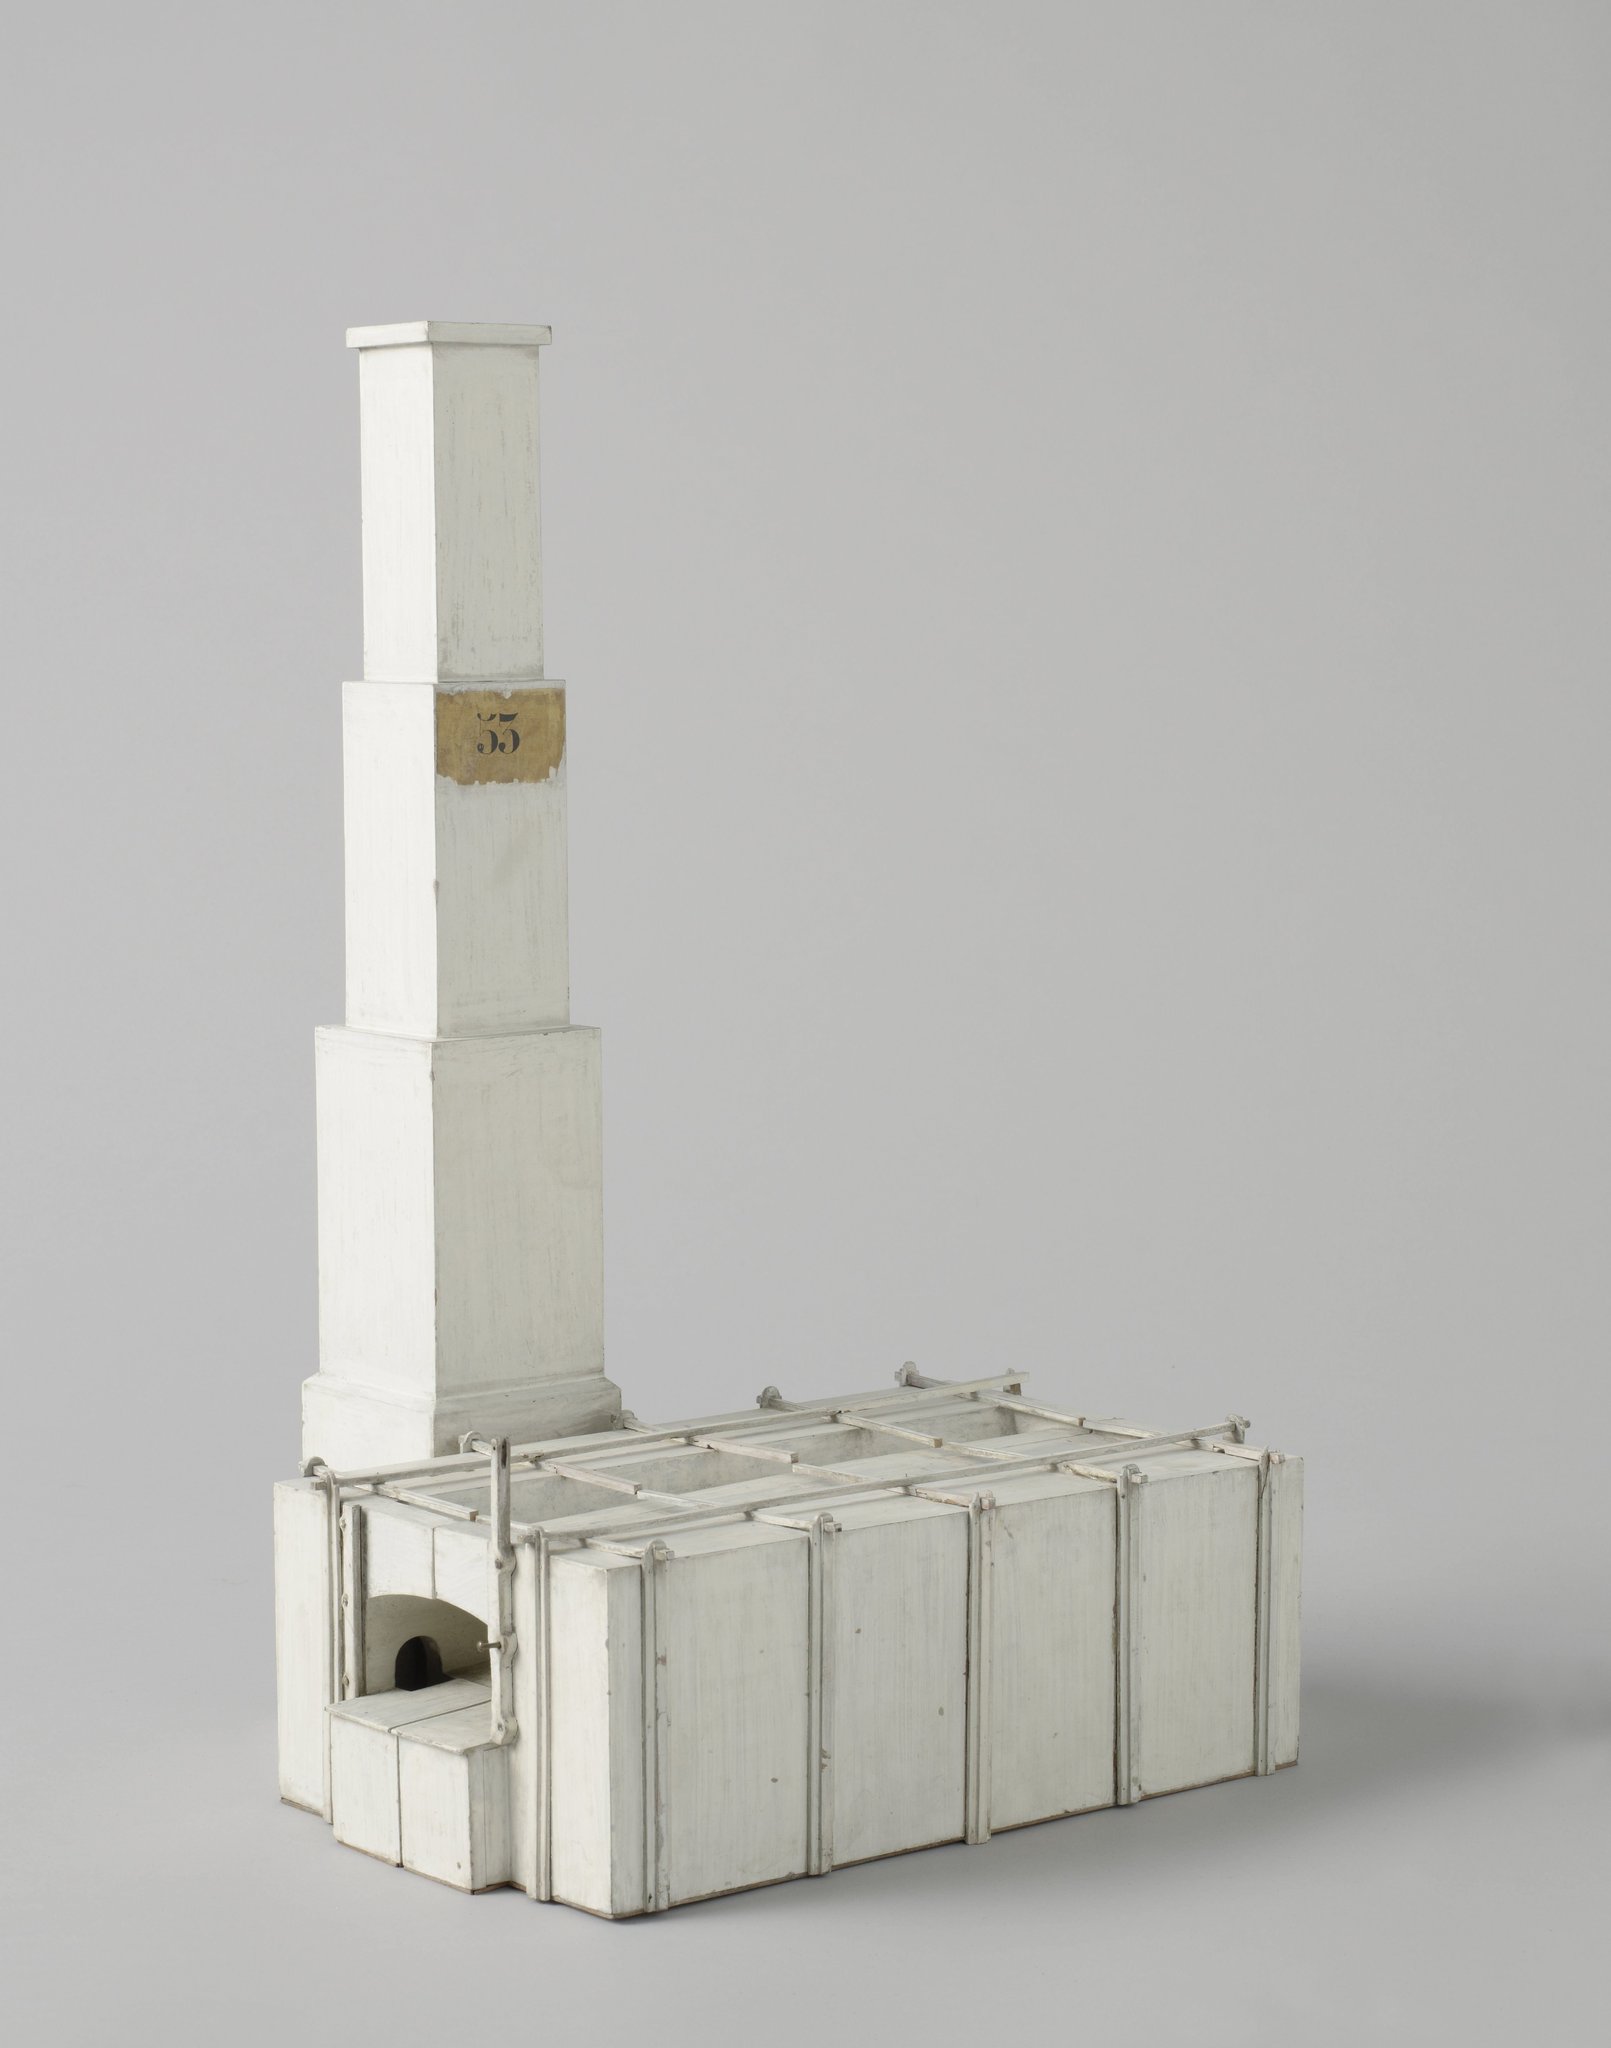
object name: demonstration model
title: Model of a Heating Furnace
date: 1820-1850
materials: brass, wood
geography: rotterdam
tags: rotterdam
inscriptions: label, on the chimney: ‘53’ former inventory label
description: Deze gloeioven werd op de voormalige Rijkswerf te Rotterdam, gesloten in 1850, gebruikt.